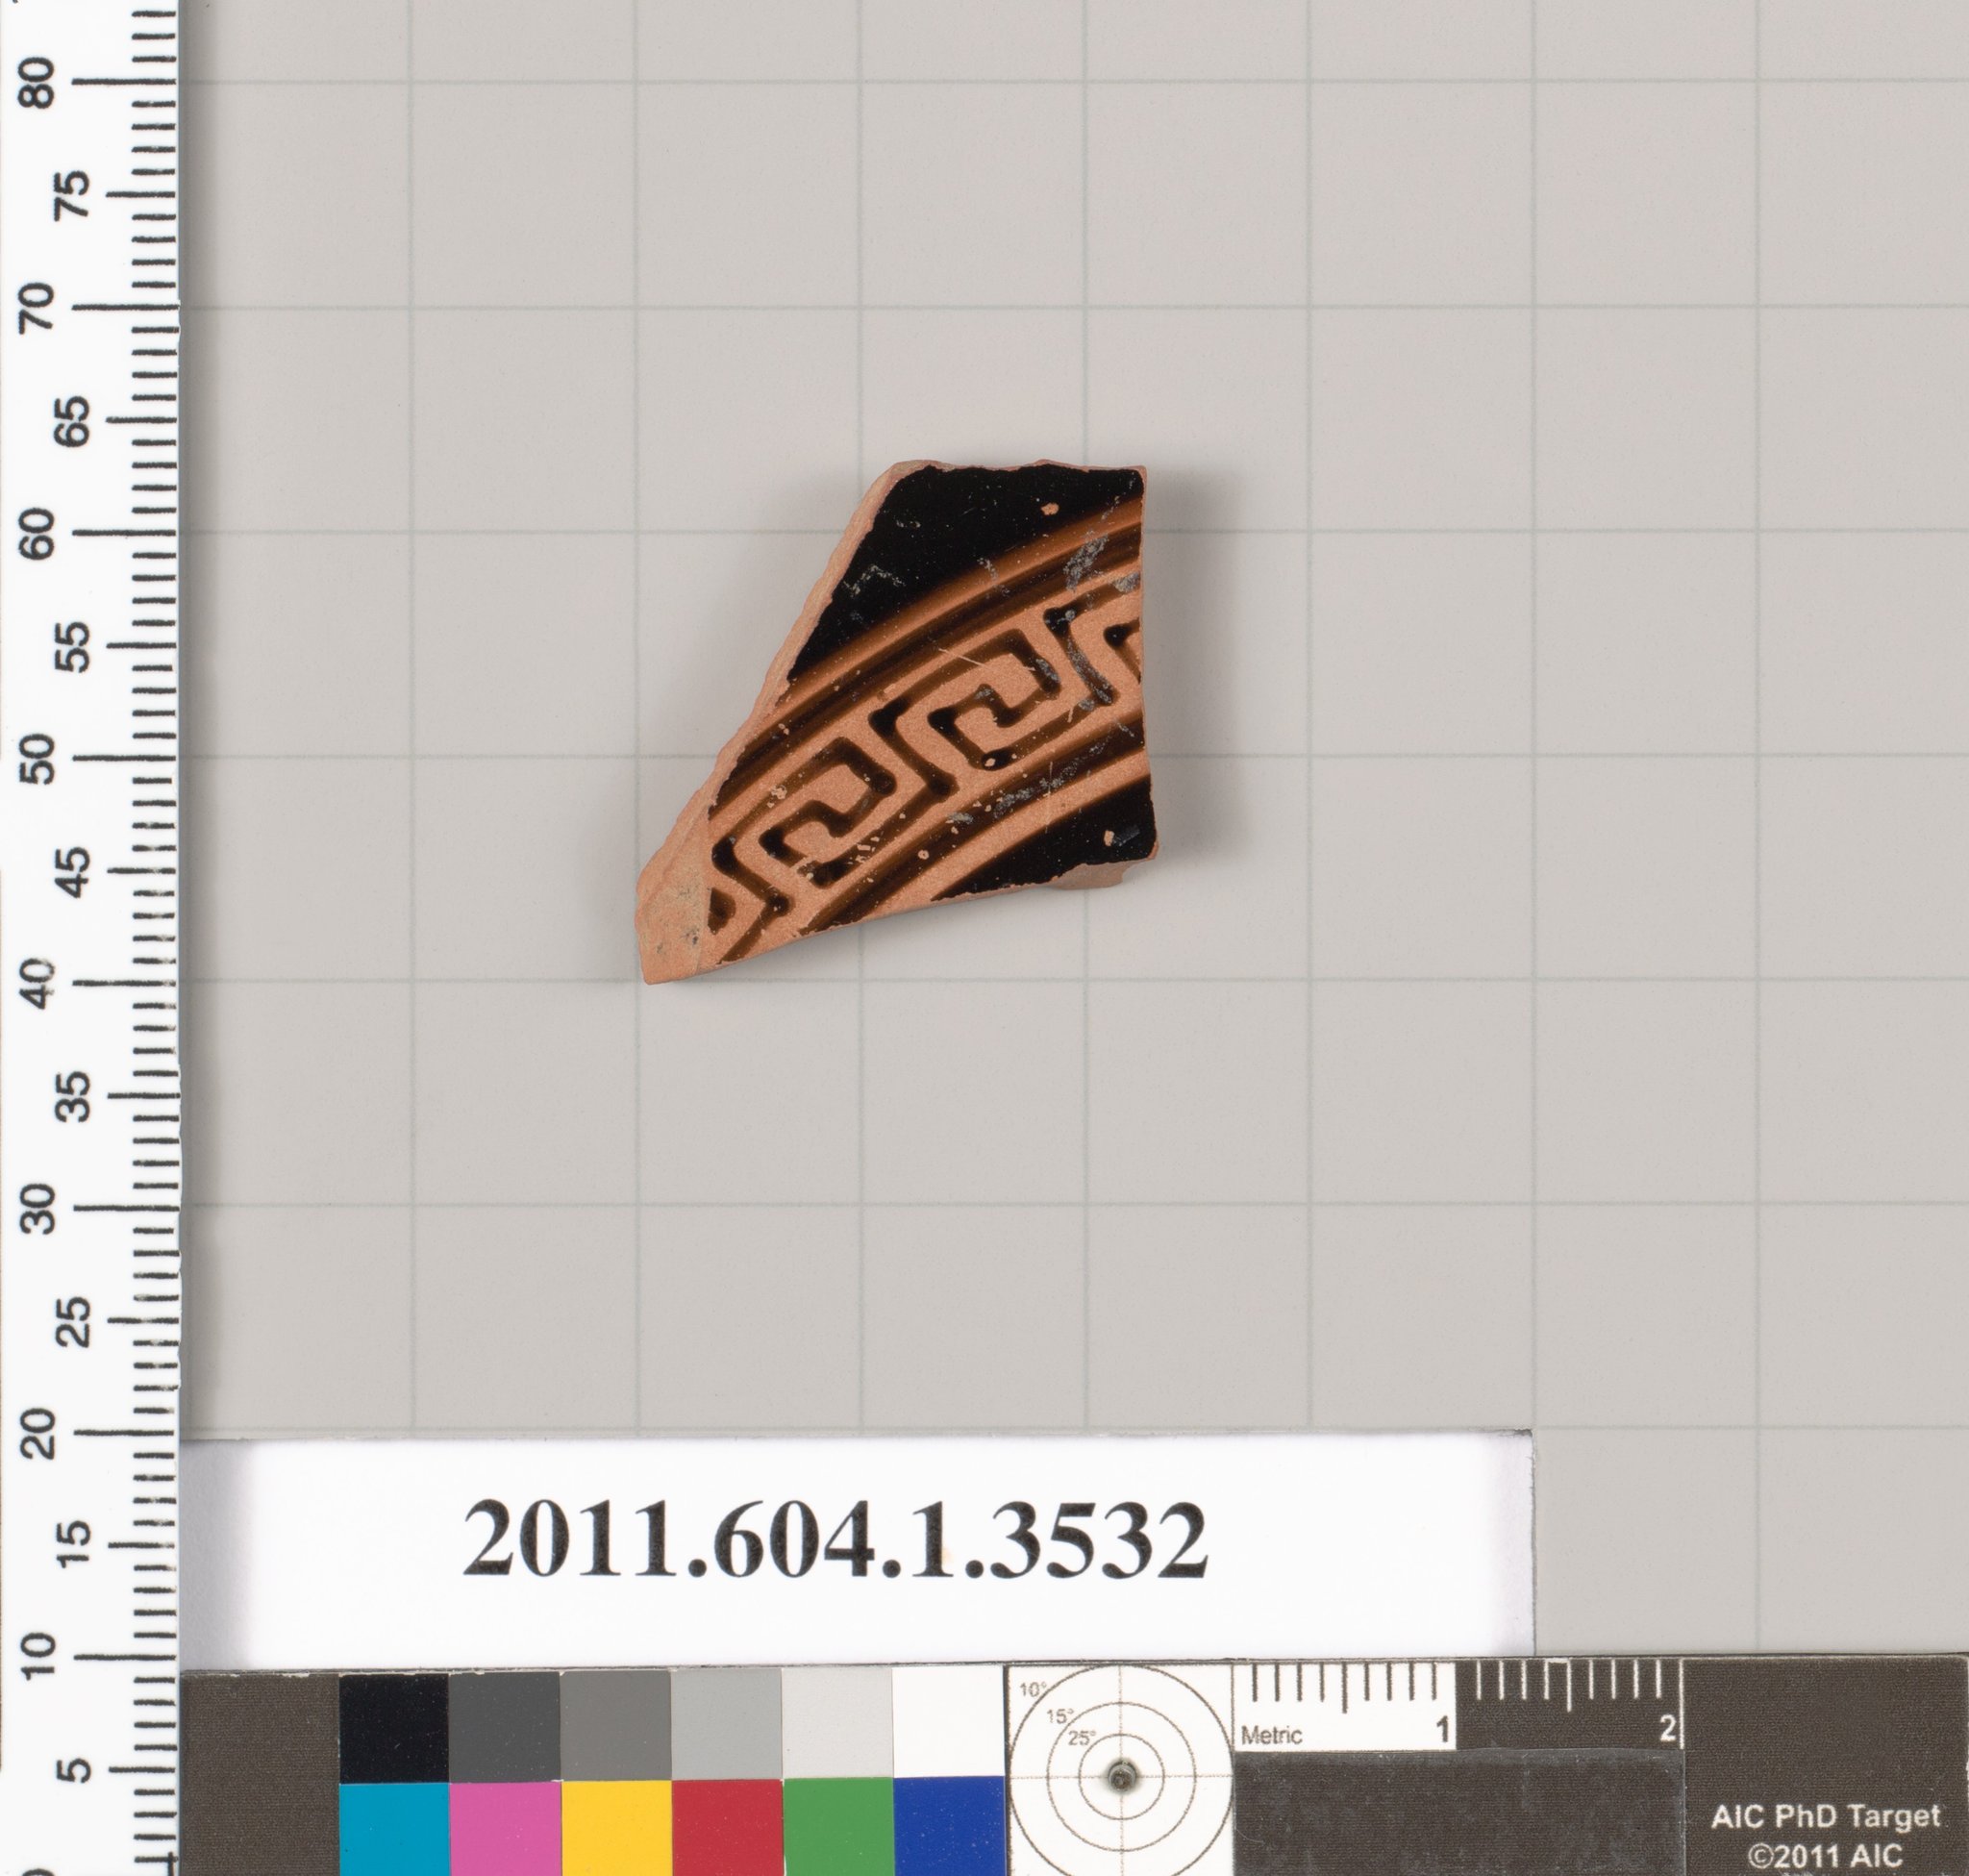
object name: kylix fragment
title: Terracotta fragment of a kylix (drinking cup)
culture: greek, attic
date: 475-451 BCE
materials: terracotta